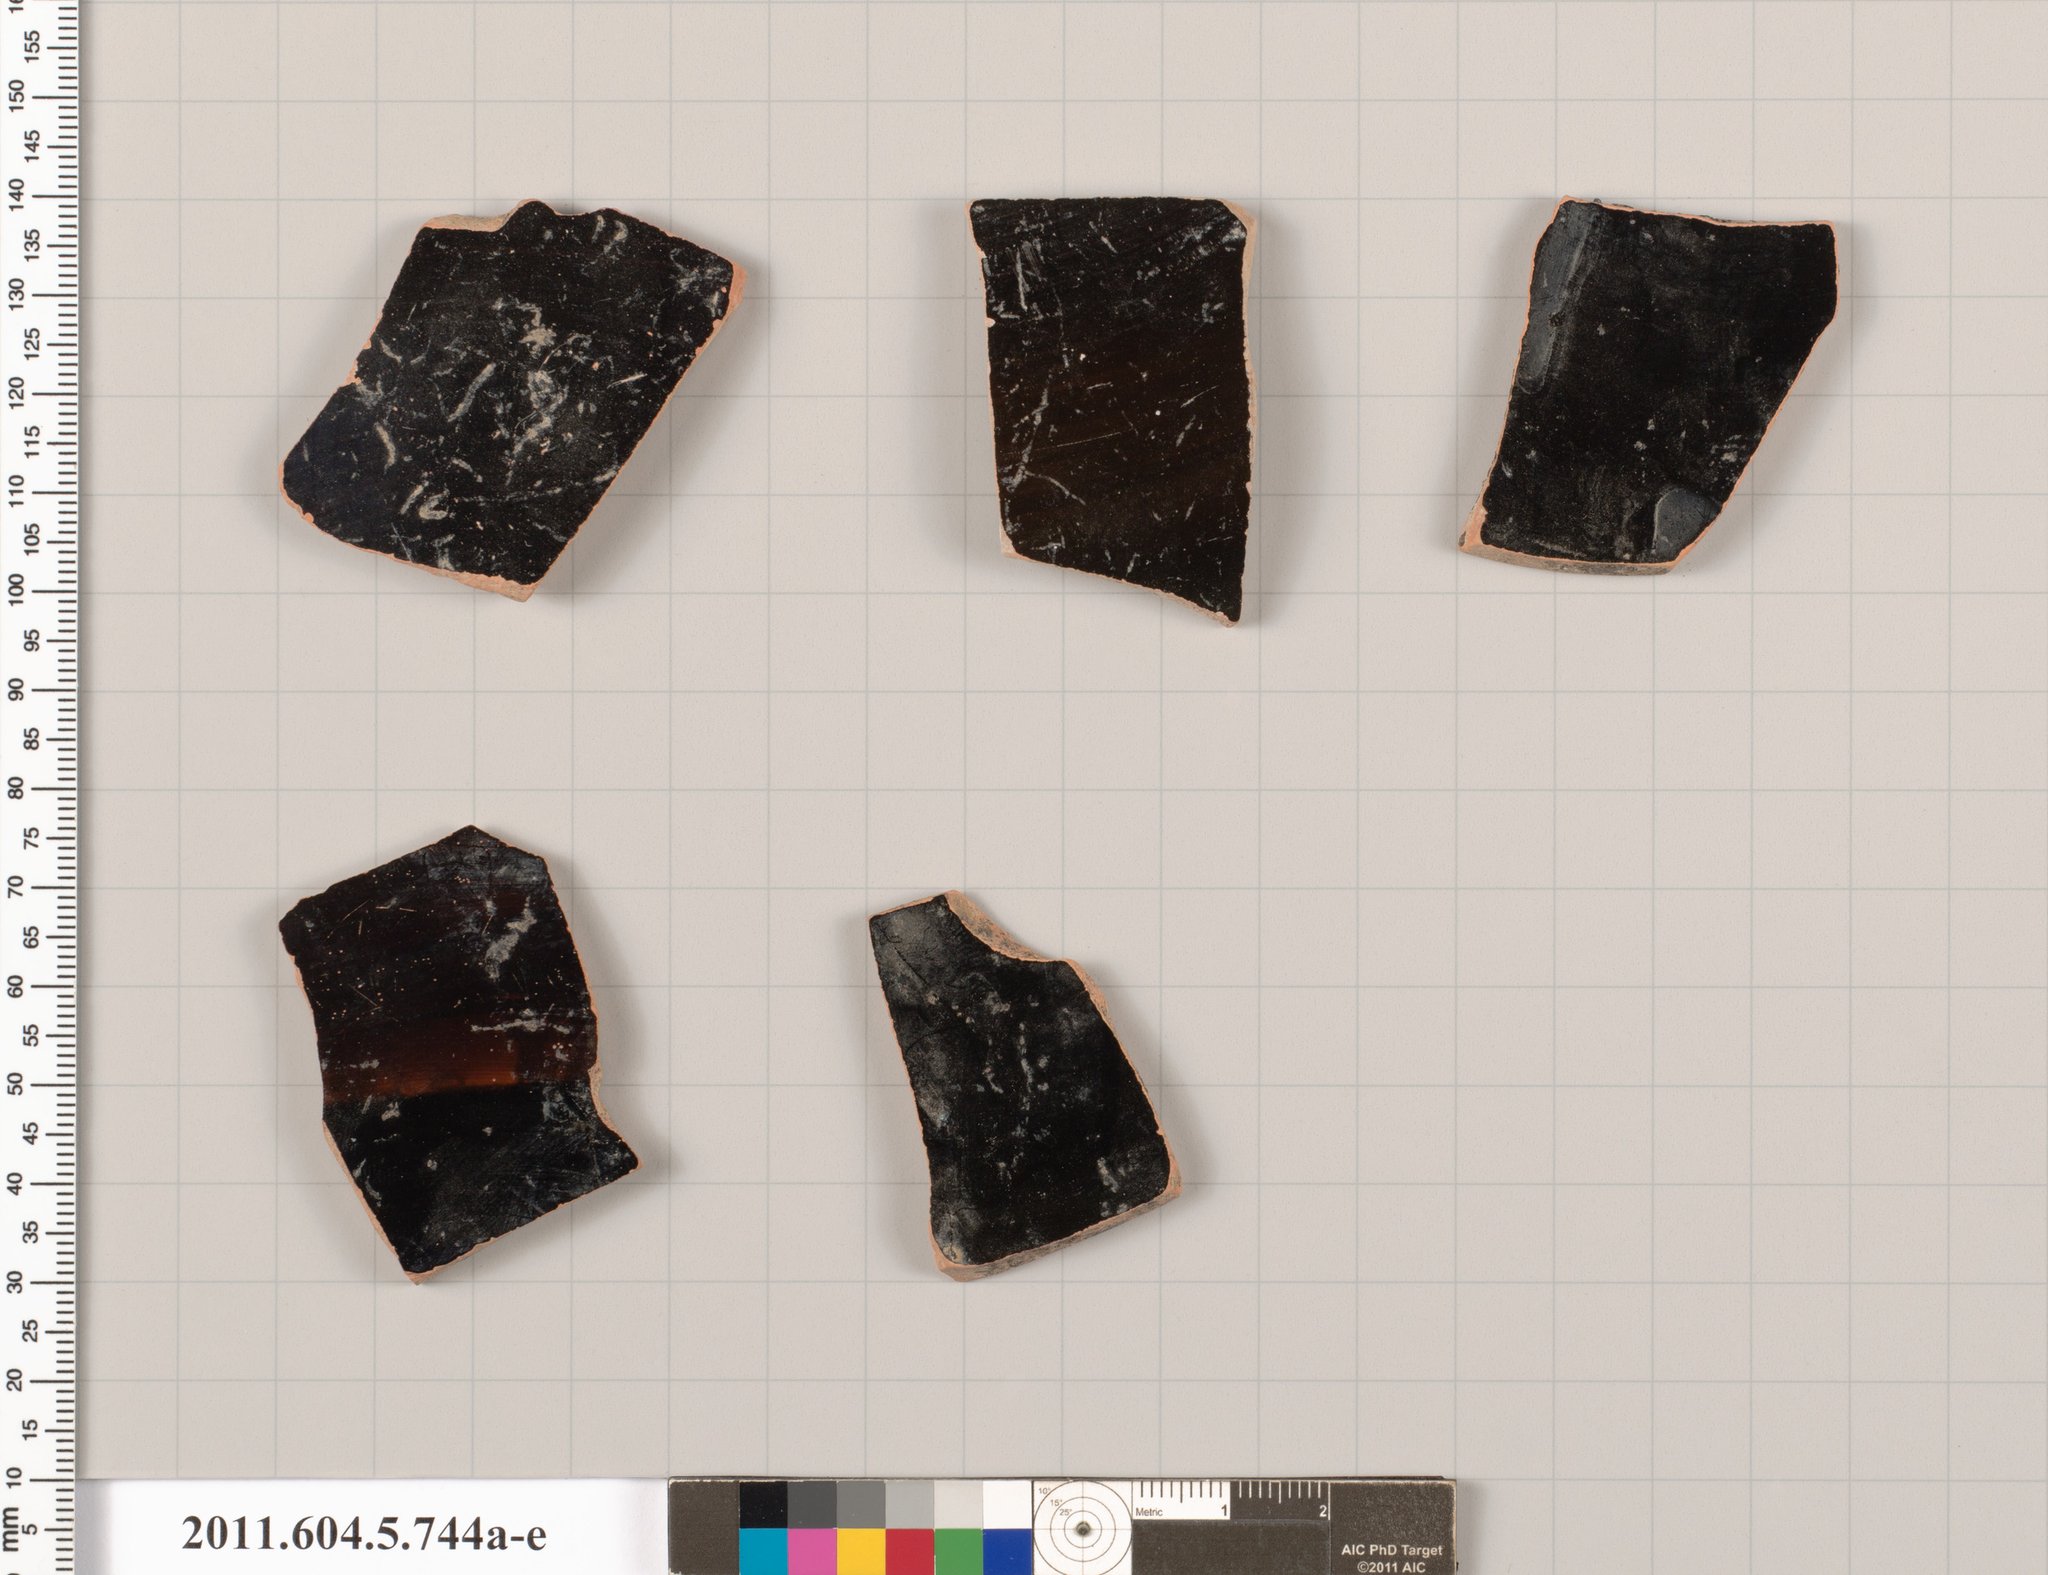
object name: kylix fragment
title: Terracotta fragments of kylikes (drinking cups)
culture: greek, attic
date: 600-401 BCE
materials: terracotta